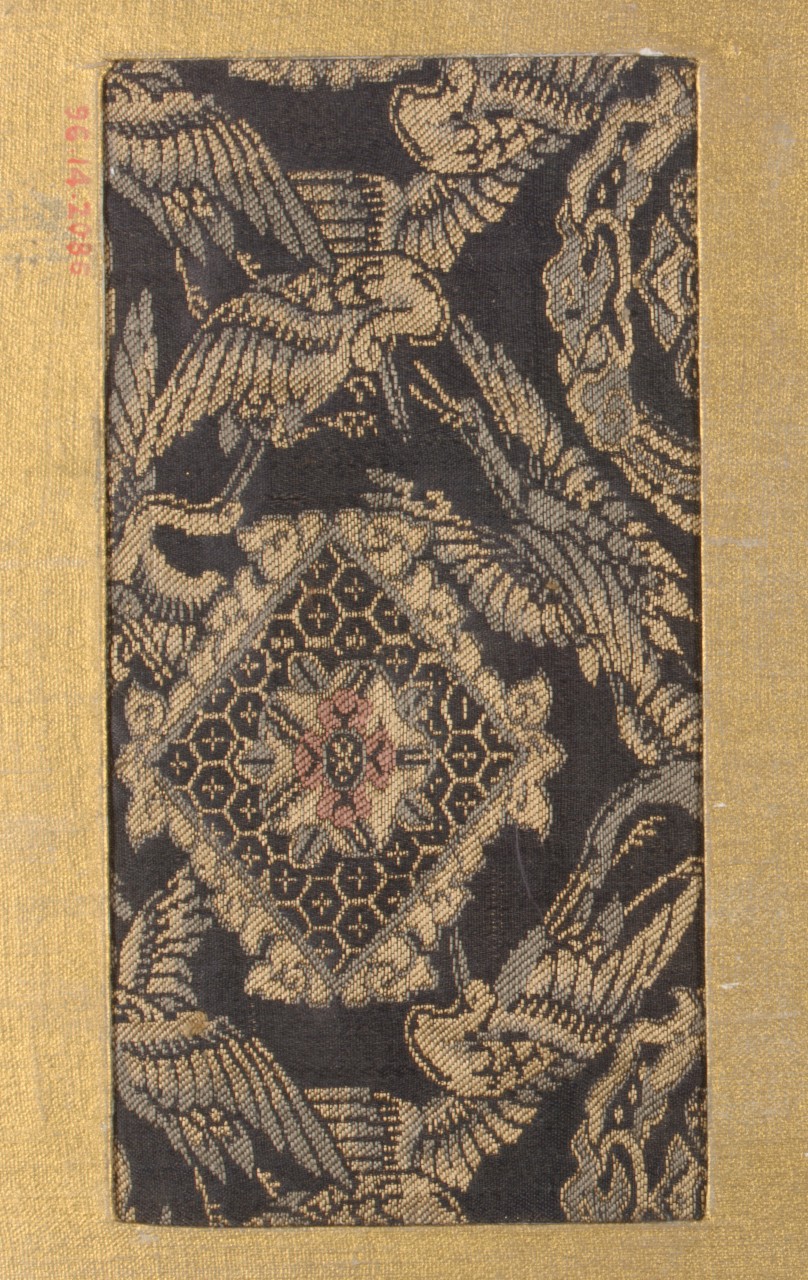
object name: piece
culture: japanese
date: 1701-1900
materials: silk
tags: birds